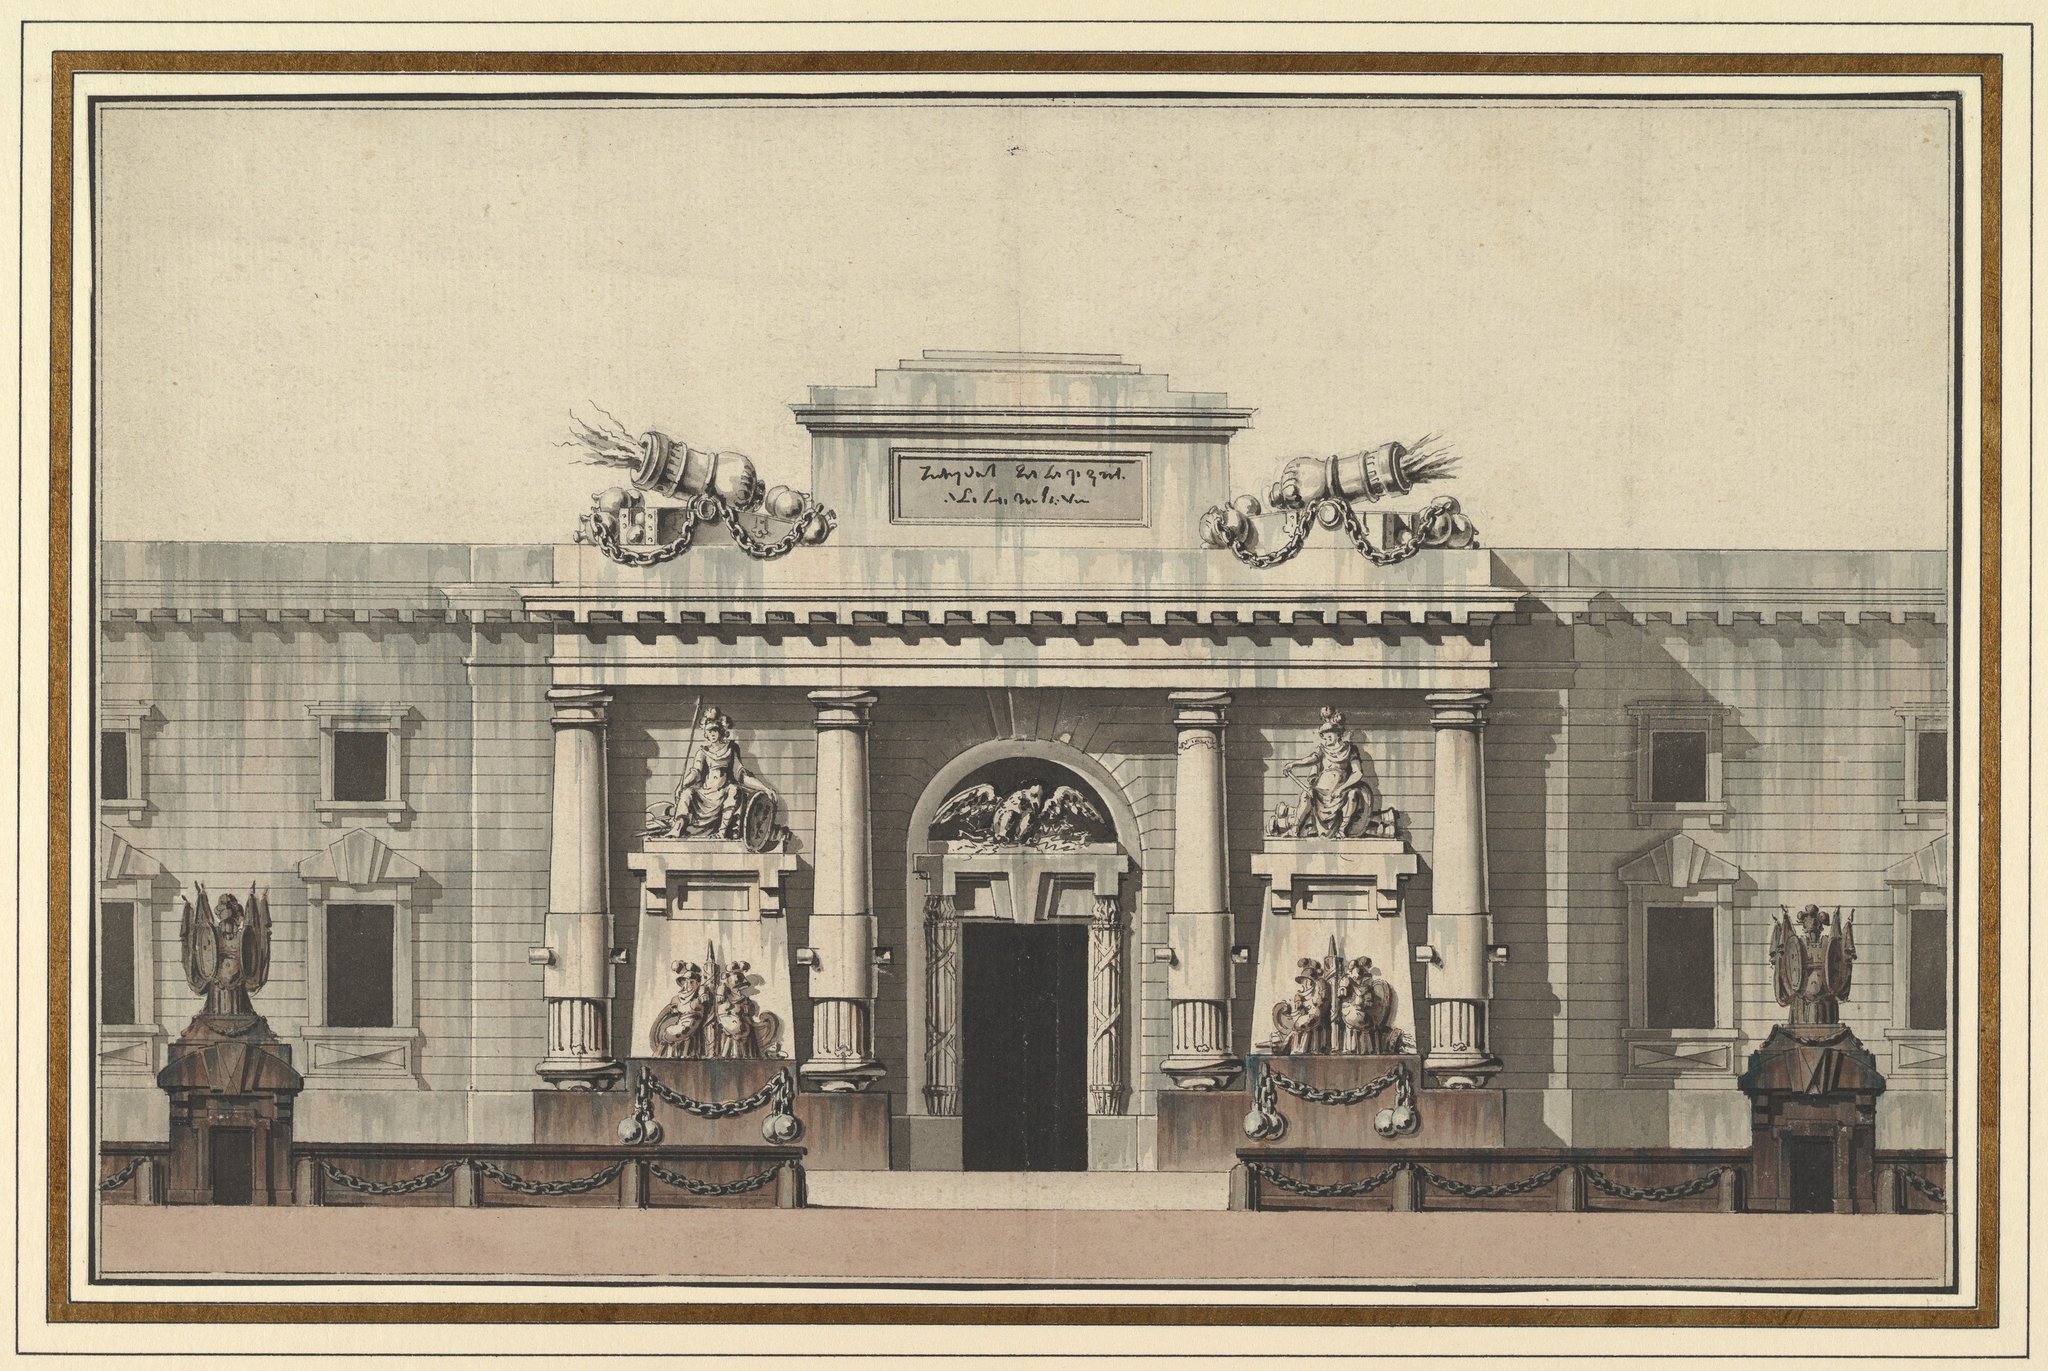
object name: drawing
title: Elevation of the Entrance to an Arsenal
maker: jean charles delafosse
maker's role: artist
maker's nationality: french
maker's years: 1734-1789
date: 1734-1789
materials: ink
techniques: brush, pen, wash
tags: buildings,doorways